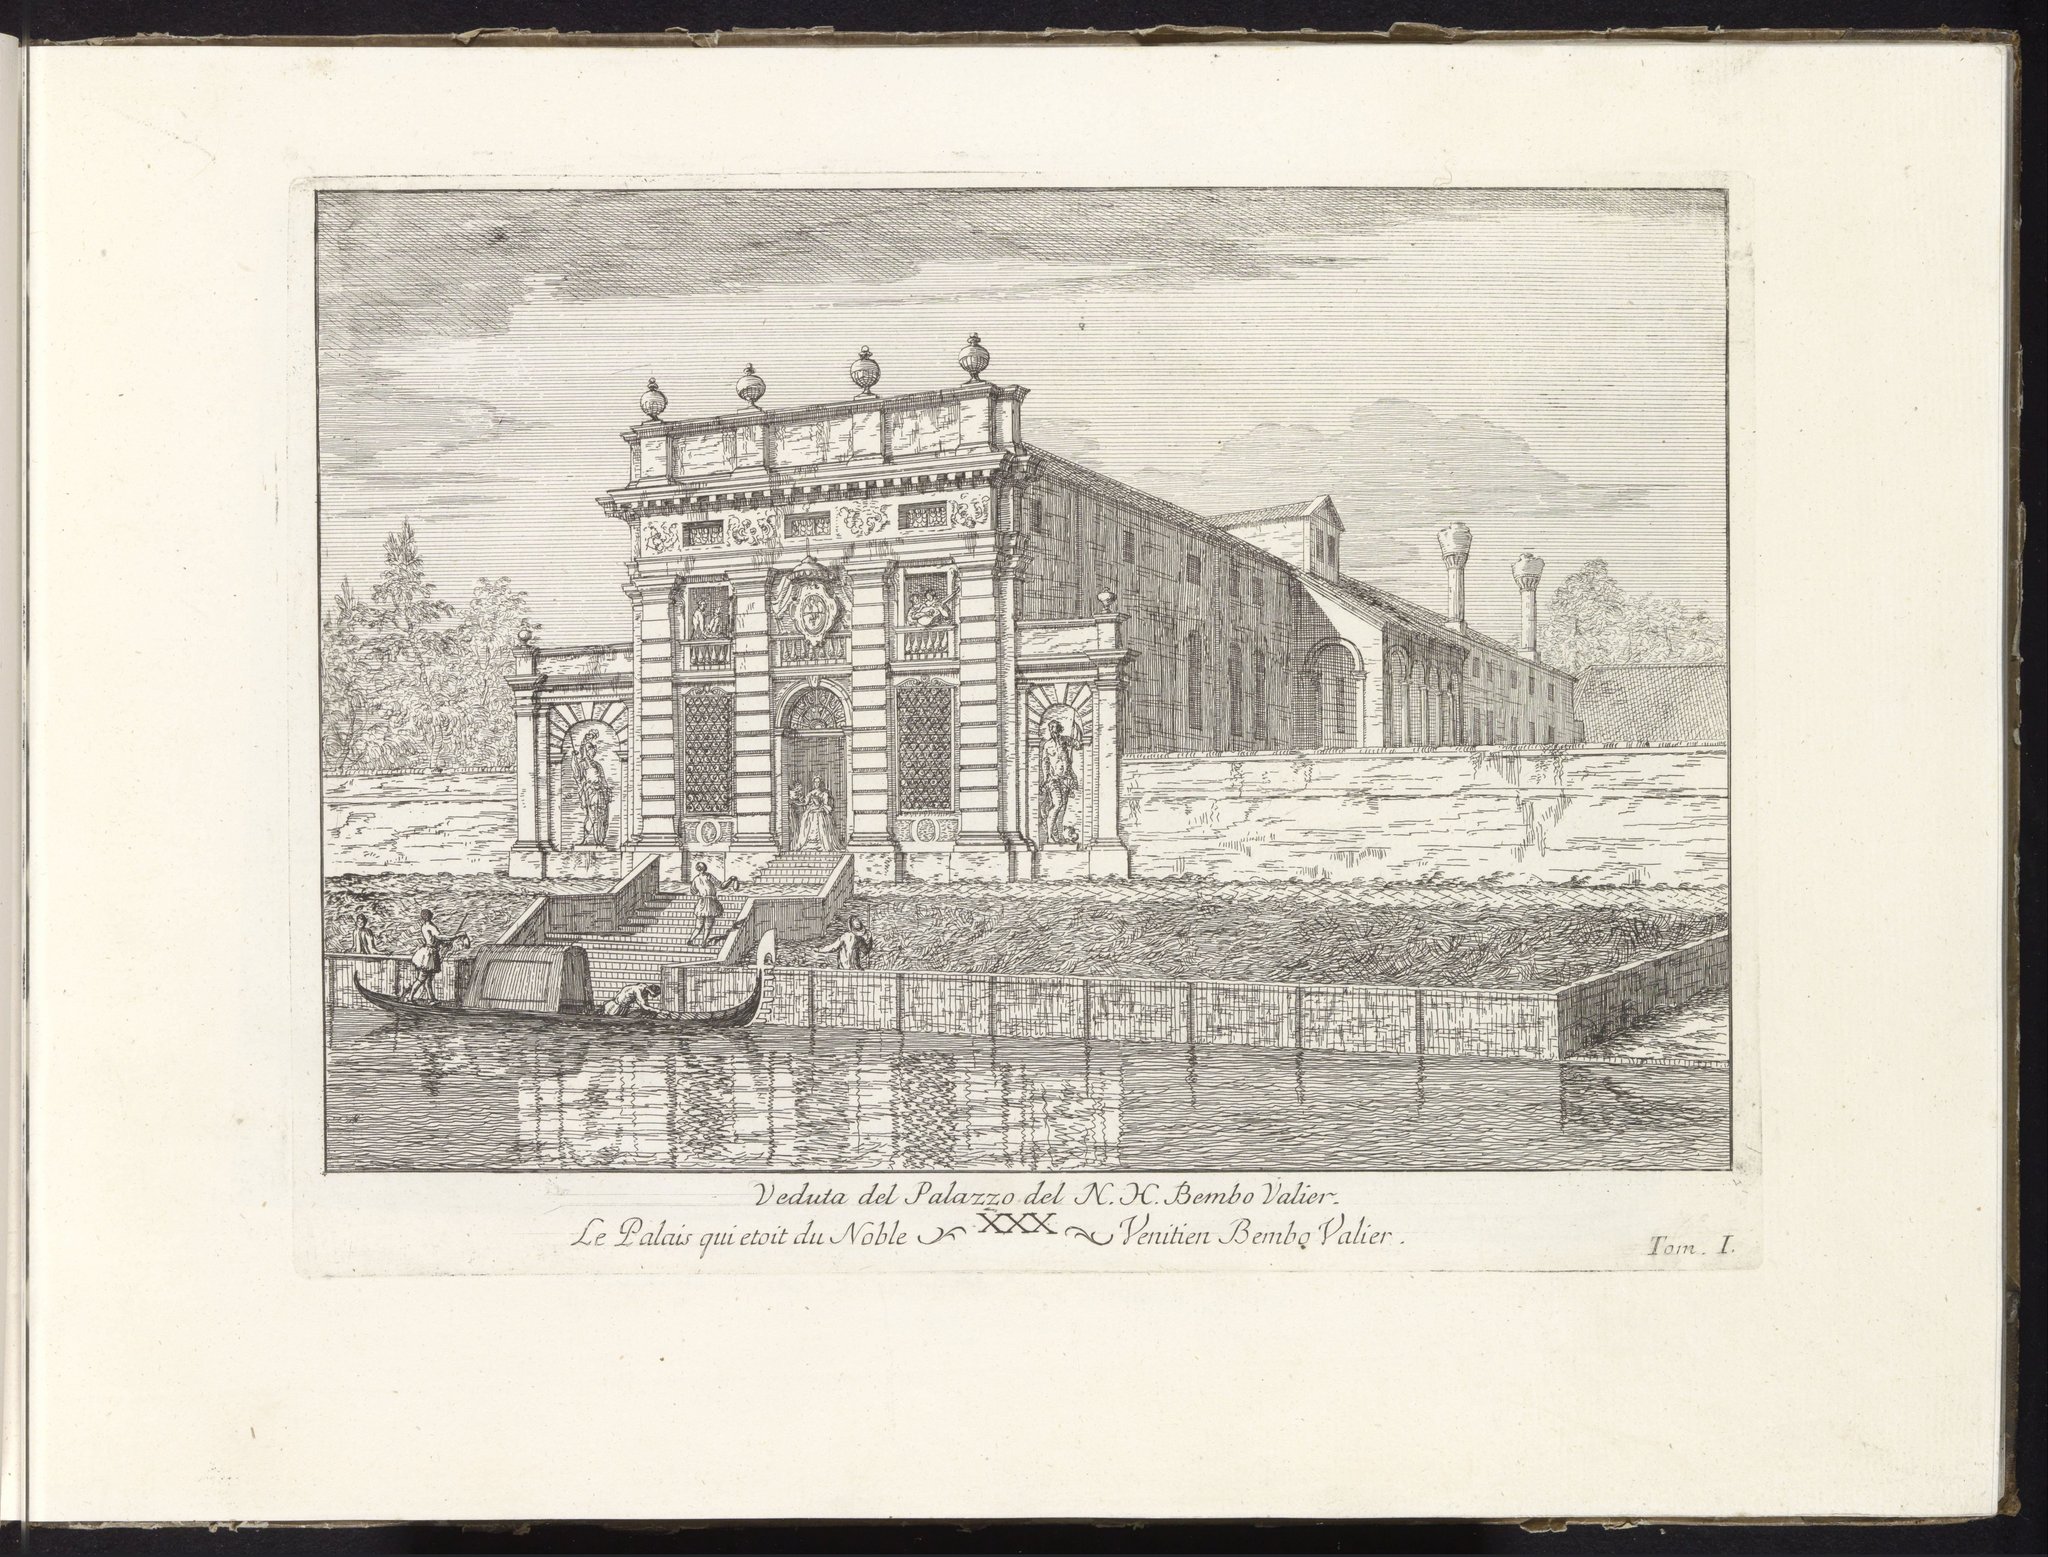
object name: print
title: Le delicie della Brenta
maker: giovanni francesco costa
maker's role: draughtsman, painter, print maker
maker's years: -1773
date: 1750-1760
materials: paper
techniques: etching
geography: italy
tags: river, hôtel, i.e. small palace in city, gondola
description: Gezicht op Palazzo del N. H. Bembo Valier aan de rivier de Brenta. Een gondel meert aan voor het paleis. Een vrouw staat in de deuropening. Genummerd midden onder: XXX en rechtsonder: Tom: I. Deze prent maakt deel uit van een album.